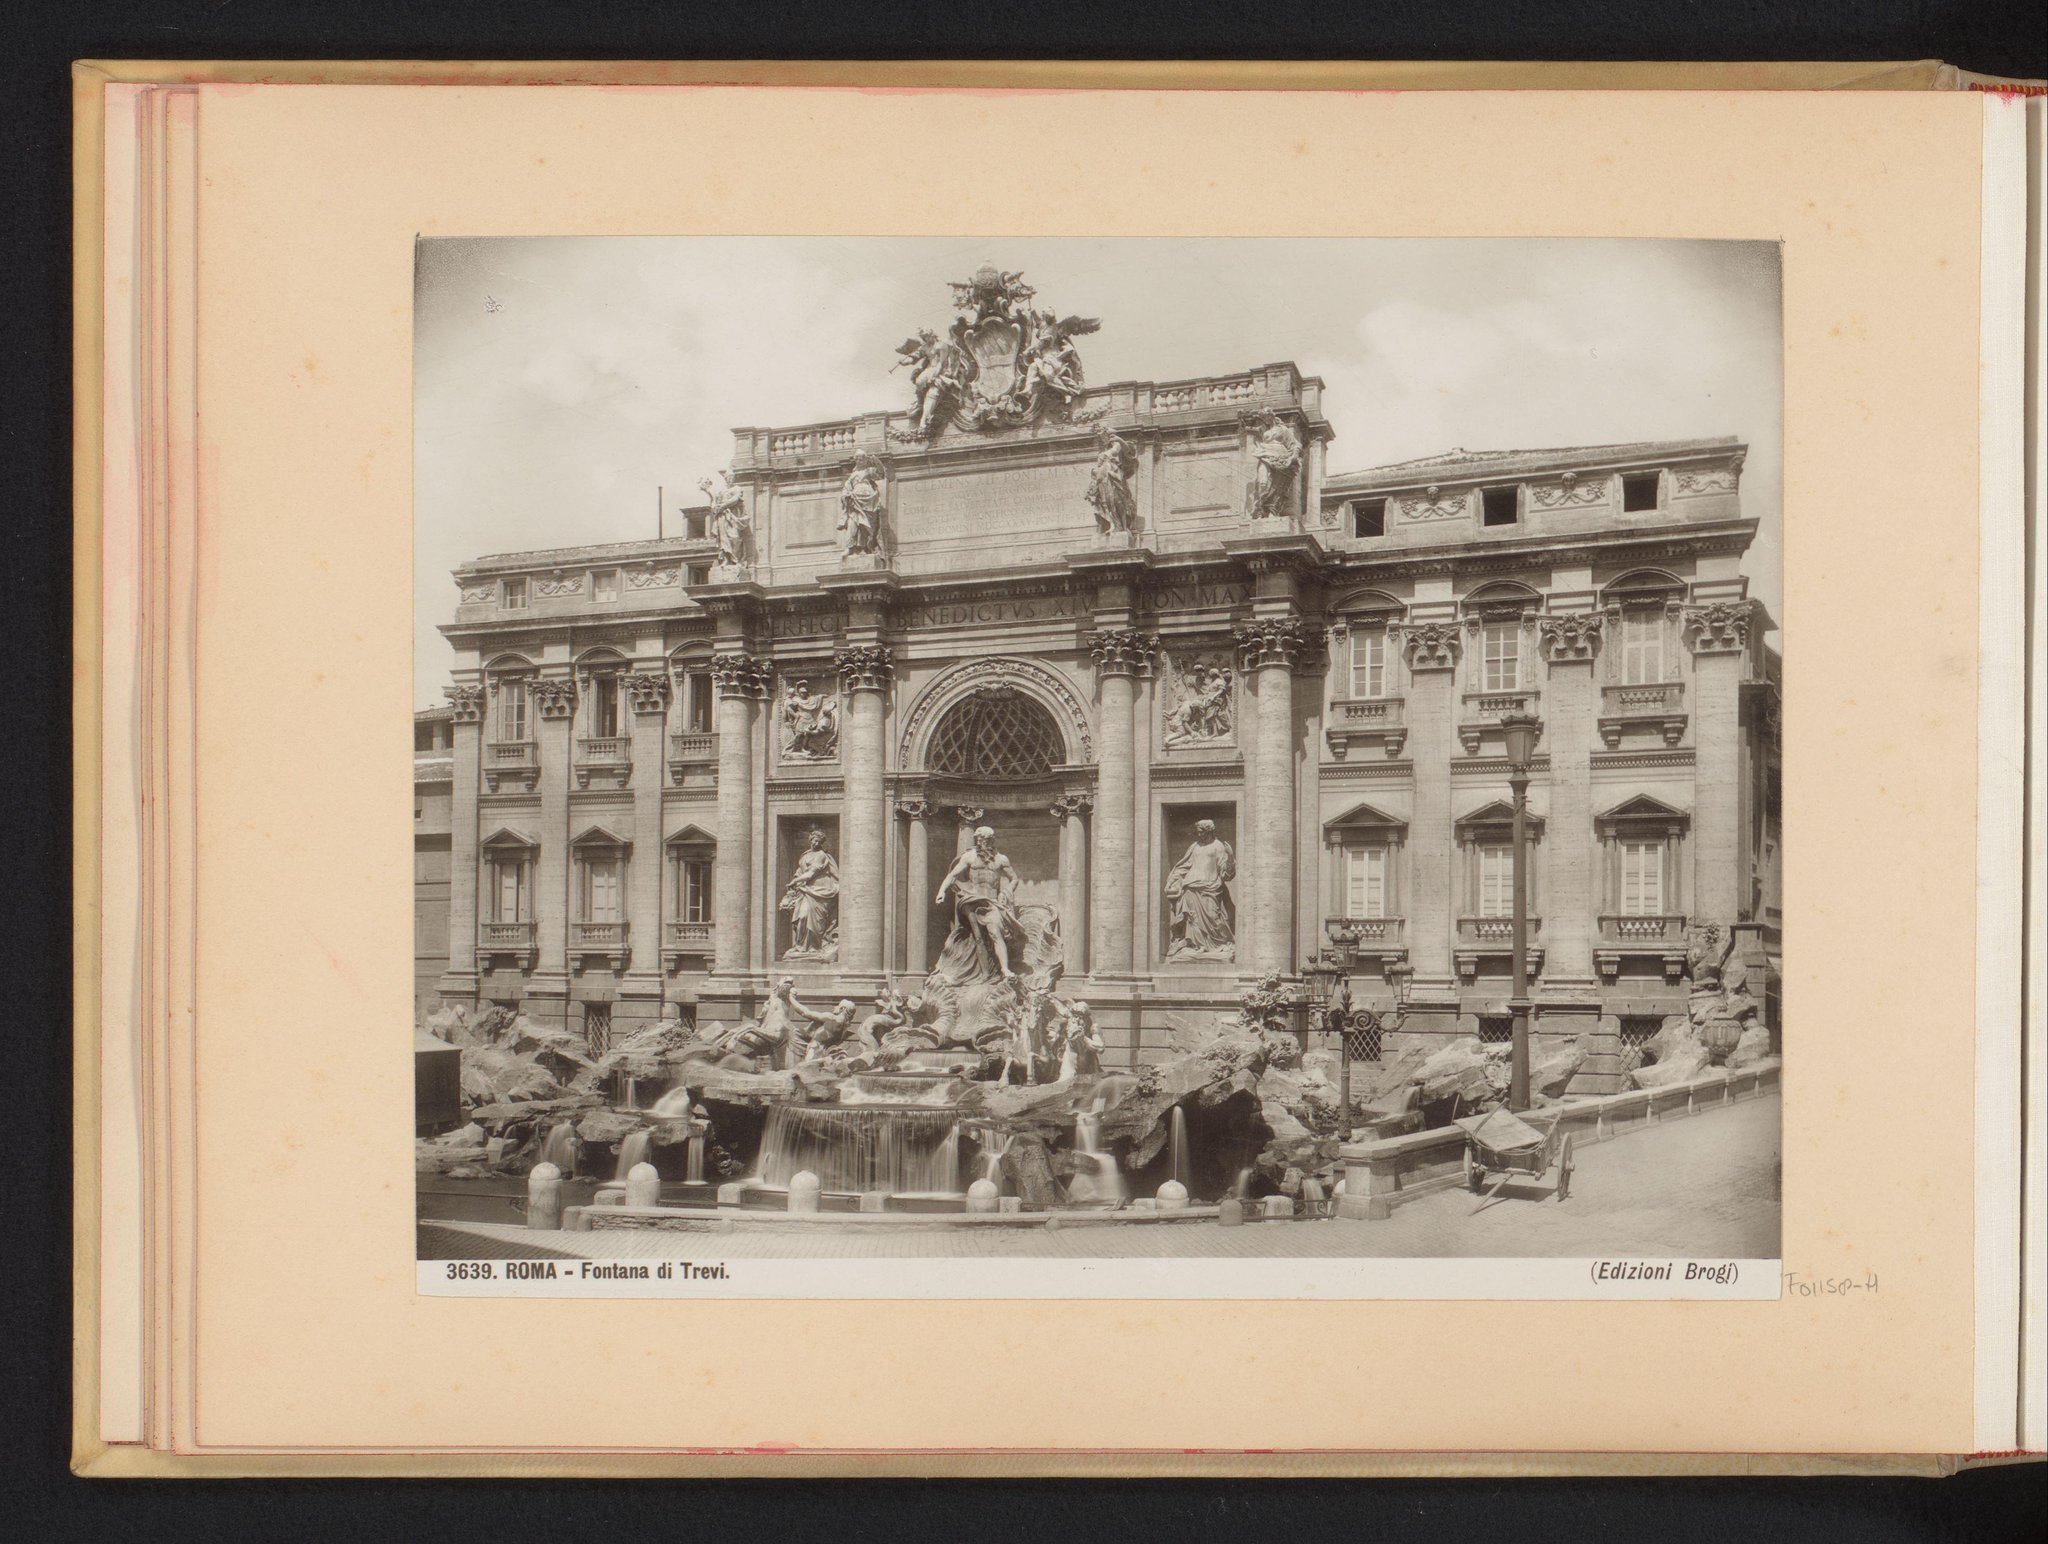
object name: photograph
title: Trevifontein te Rome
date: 1875-1907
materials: photographic support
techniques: gelatin silver print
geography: rome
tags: ornamental fountain, sculpture, neptune as lord of the sea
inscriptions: number: ‘3639’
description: Onderdeel van Fotoalbum met opnames van bezienswaardigheden en kunstwerken in Italië.